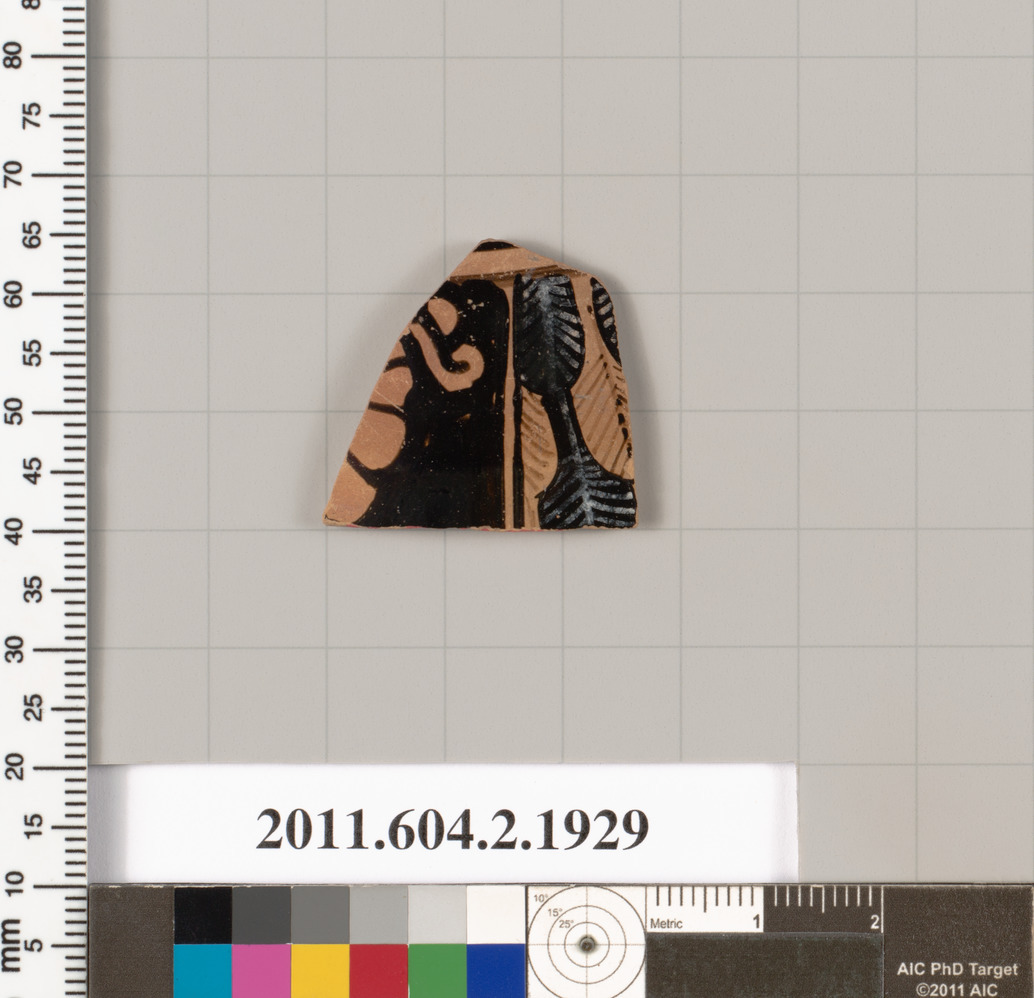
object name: skyphos fragment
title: Terracotta fragment of a skyphos (deep drinking cup)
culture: greek, attic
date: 475-425 BCE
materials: terracotta